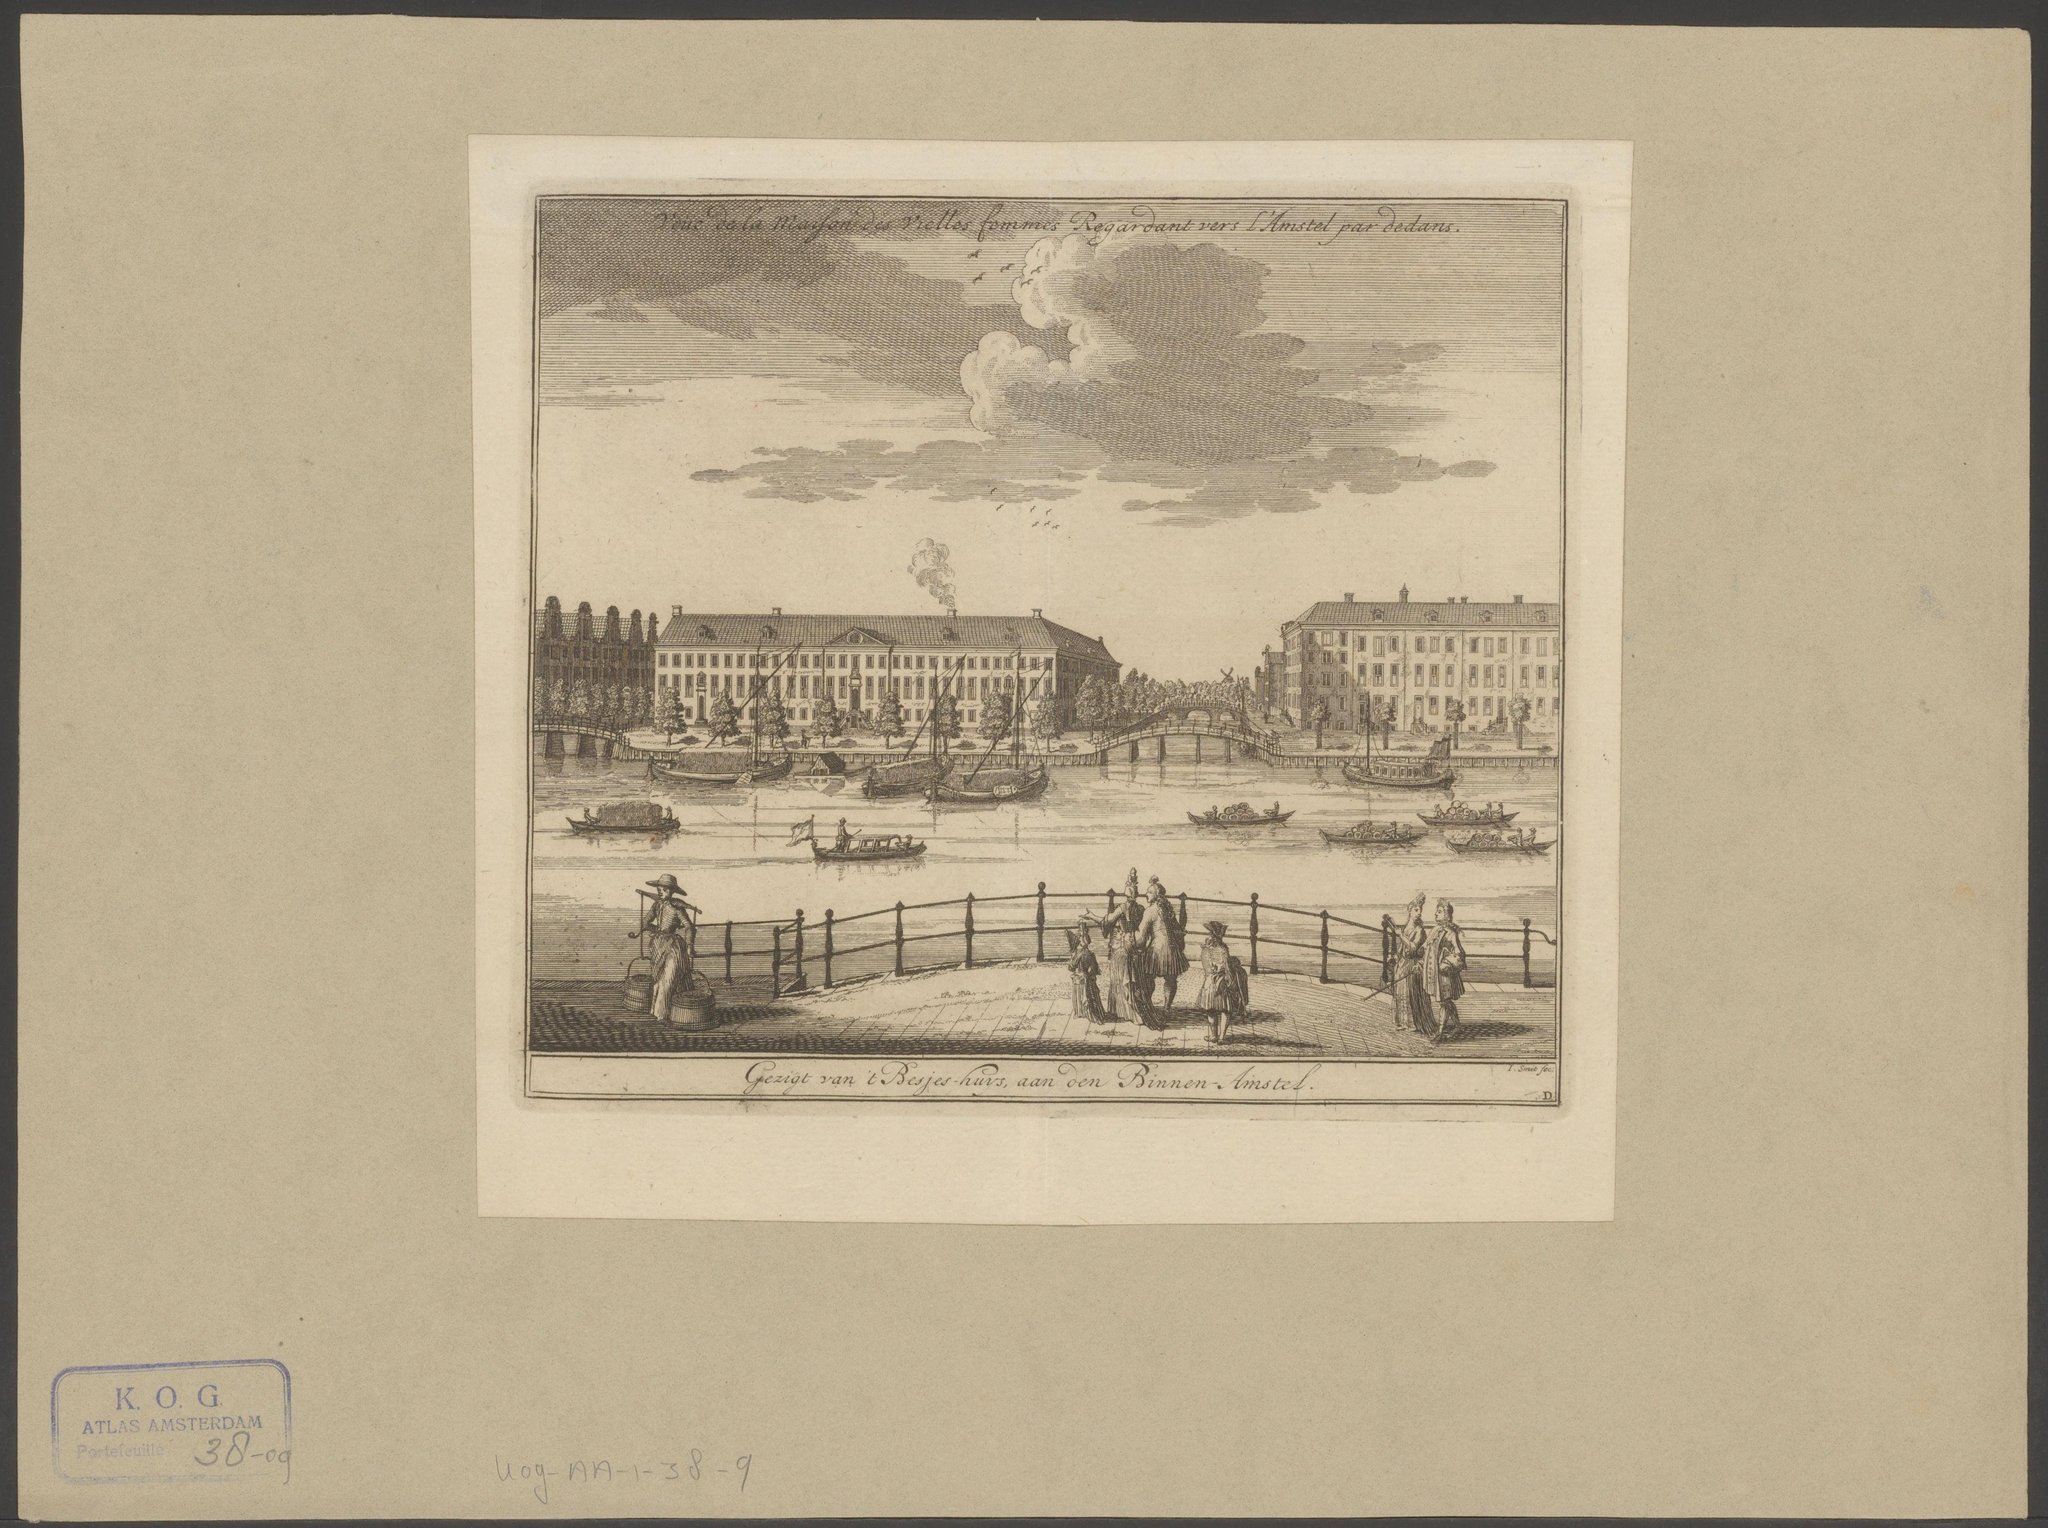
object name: print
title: Veüe de la Maison des Vielles femmes Regardant vers l'Amstel par dedans / Gezigt van 't Besjes-huys, aan den Binnen-Amstel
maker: hendrik de leth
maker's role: draughtsman, print maker, publisher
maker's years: 1703-1766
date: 1740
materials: paper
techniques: engraving, etching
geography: amsterdam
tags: bridge in city across river, canal, etc. (+ city(-scape) with figures, staffage), ships (in general), canals, waters (in city) (+ city(-scape) with figures, staffage), old-people's home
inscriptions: collector's mark: Lugt 1641b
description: Rechtsonder gemerkt: D. Onderwerpsrubriek binnen de Atlas Amsterdam: Armwezen en liefdadige instellingen: II. Kerkelijke inrichtingen: Diaconie Oude Mannen- en Vrouwenhuis der Ned. Herv. Gem.